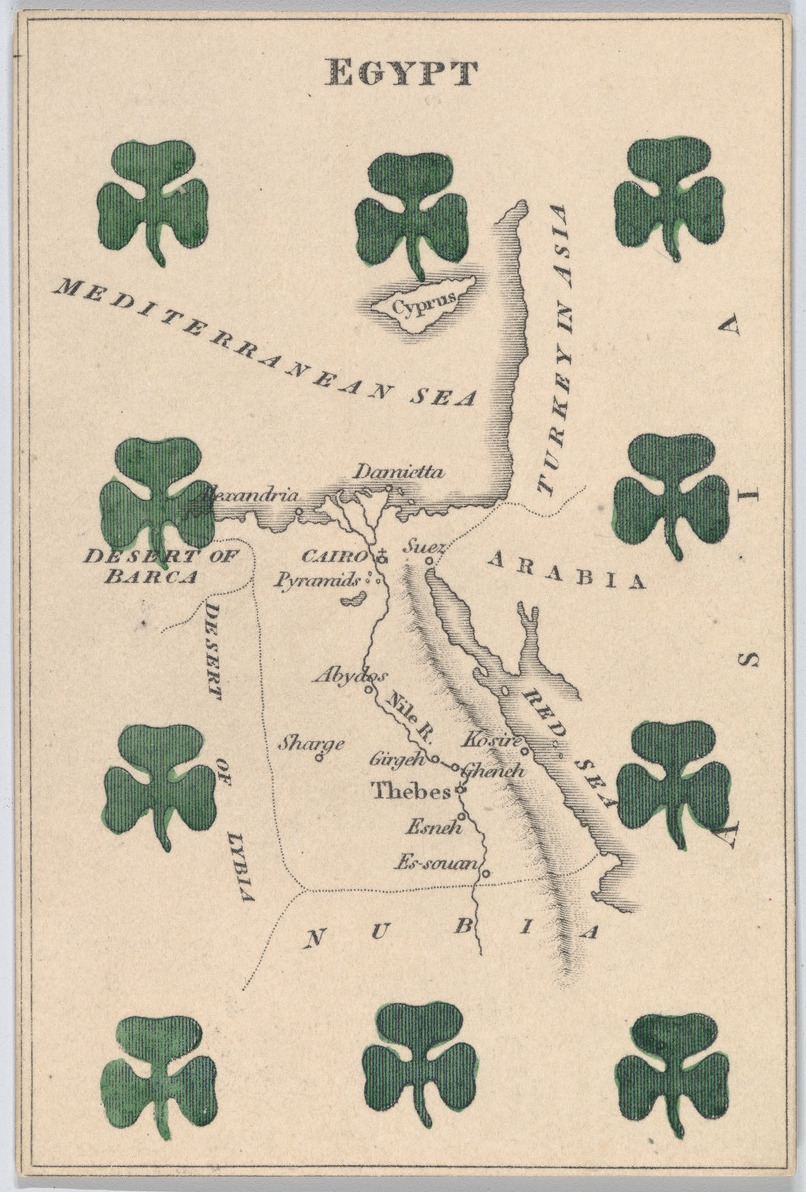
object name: print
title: Egypt, from "Court Game of Geography"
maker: william and henry rock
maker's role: publisher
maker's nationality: british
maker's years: 1821-1884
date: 1838-1855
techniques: engraving, hand coloring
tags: playing cards,maps